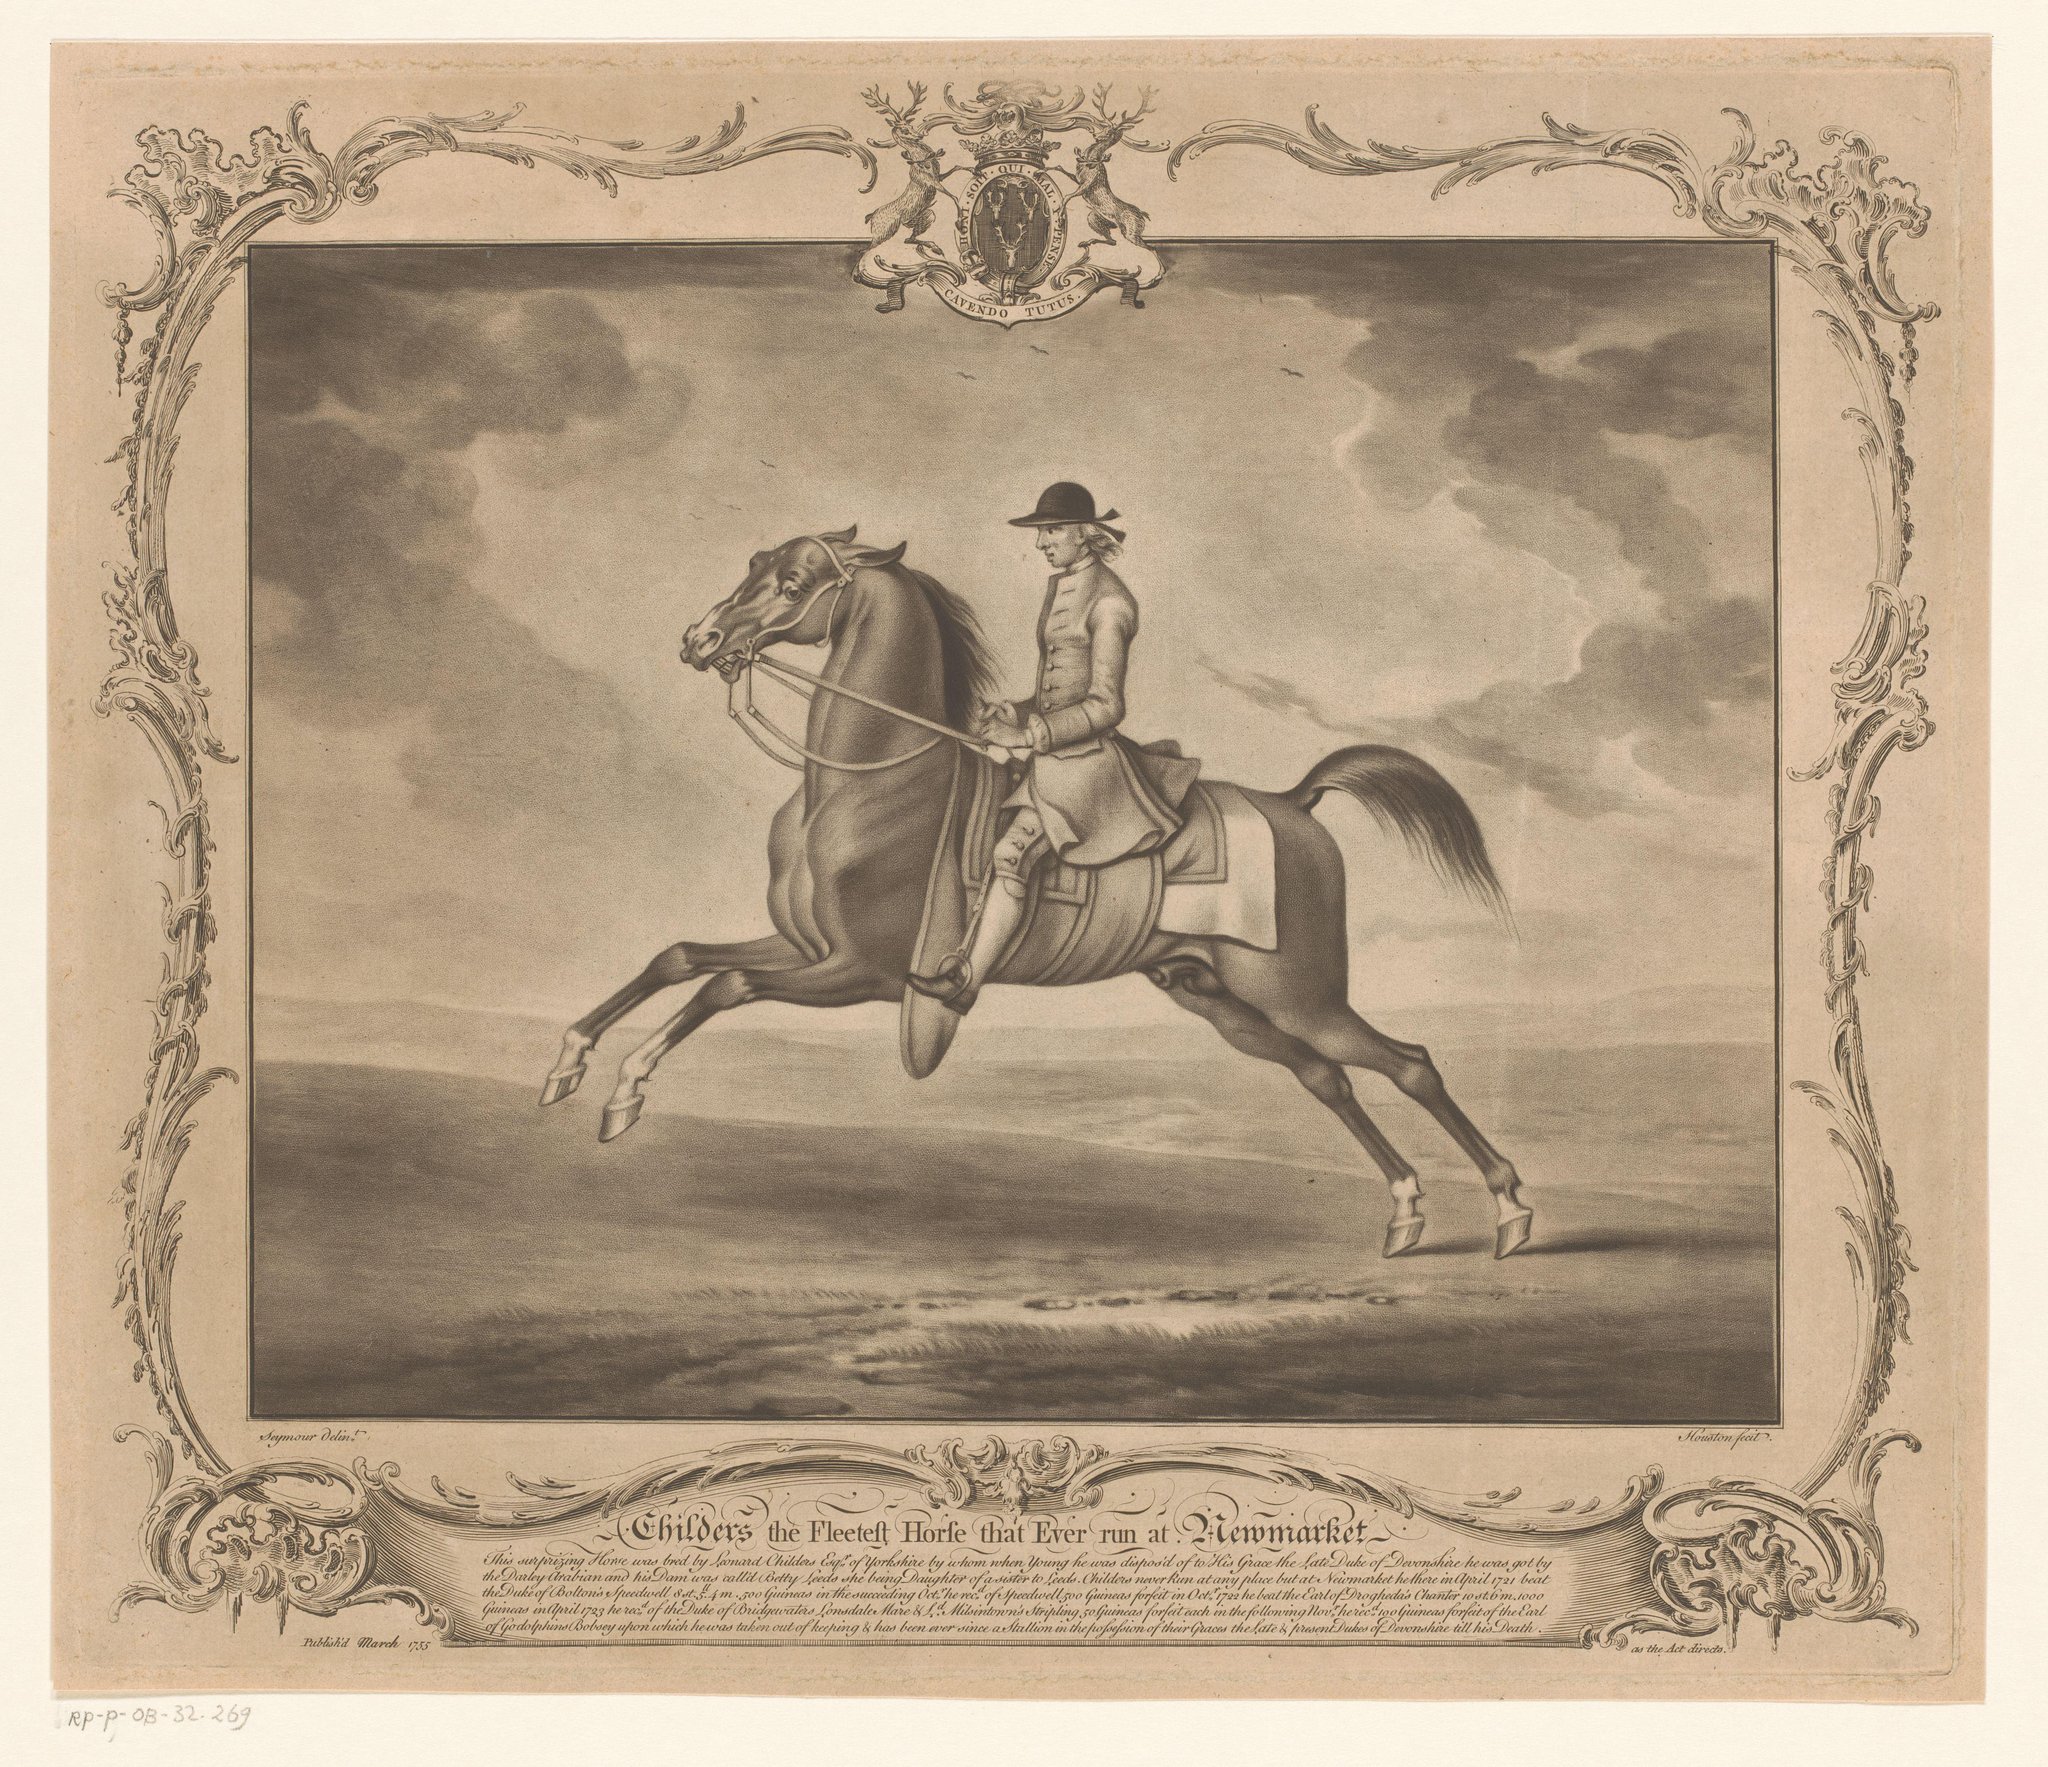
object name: print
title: Racepaard met jockey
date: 1755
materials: paper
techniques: etching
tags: horse-racing, jockey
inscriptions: collector's mark: Lugt 2228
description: Tekst in het Engels in de ondermarge. De omkadering bevat een wapenschild met herten.